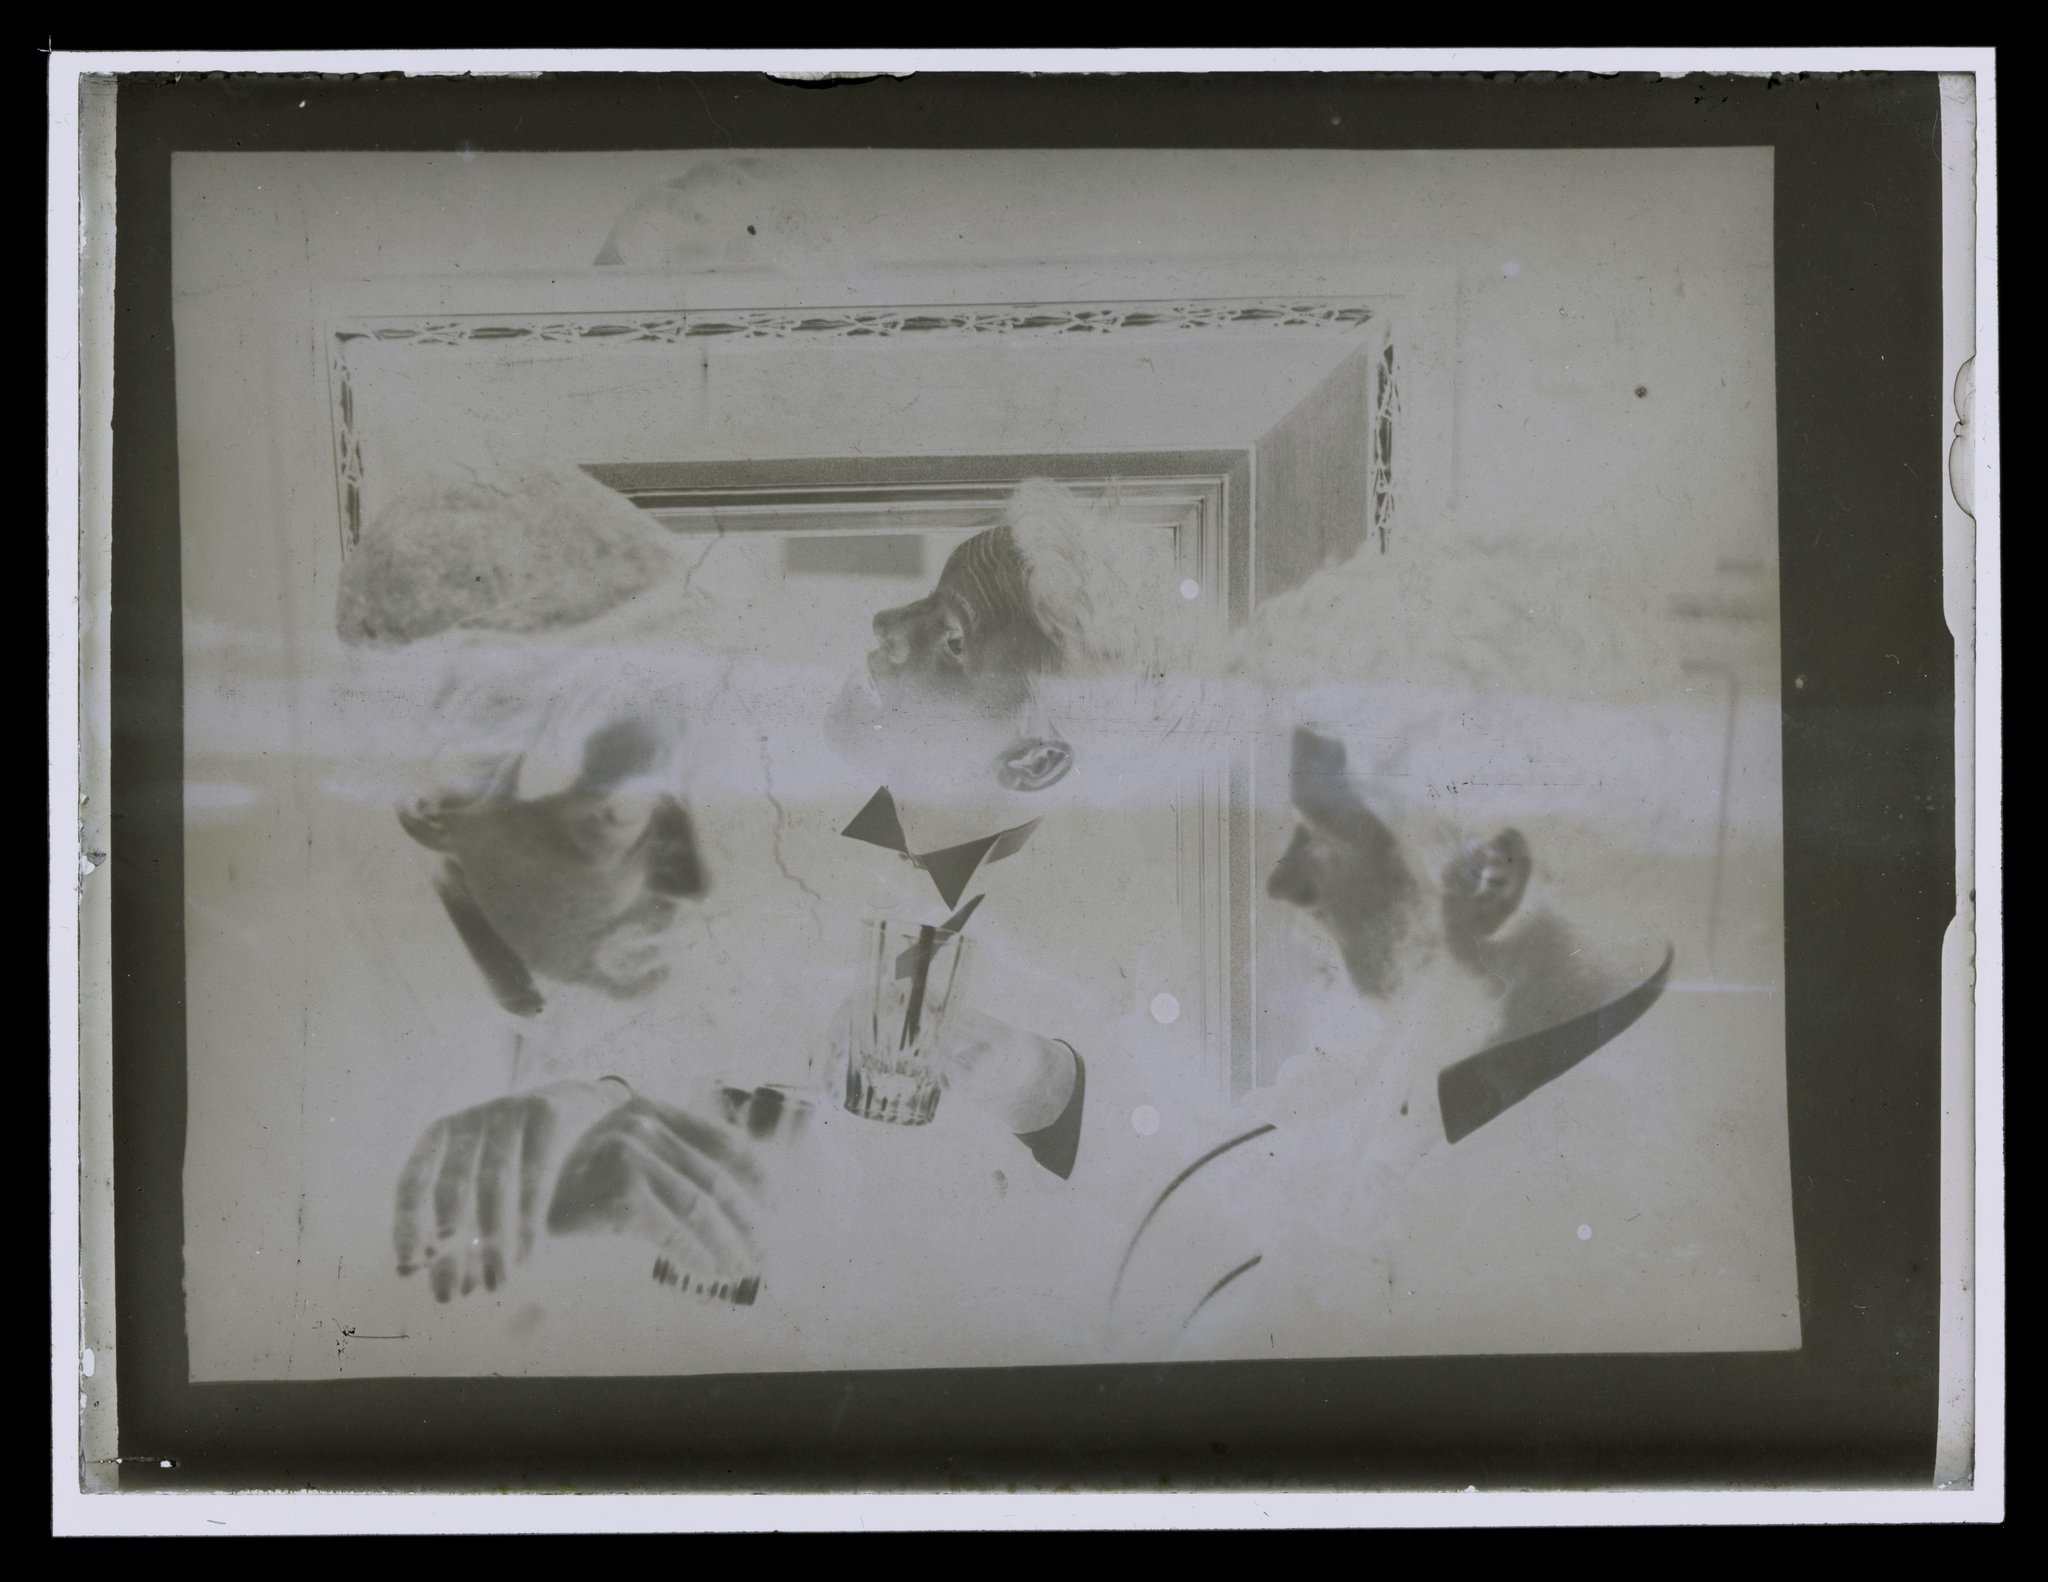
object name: glasnegatief, glasplaatnegatief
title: Portret van Willem Kloos, Pet Tideman (in een schilderijenlijst) en Hein Boeken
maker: wouterus gijsbertus hondius van den broek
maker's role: amateurfotograaf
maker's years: 1867-1913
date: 1895-1925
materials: glass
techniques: gelatin glass negative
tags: the hague, willem kloos, hein boeken, hoorn (north holland), pet tideman, historical persons, frame of painting, etc.